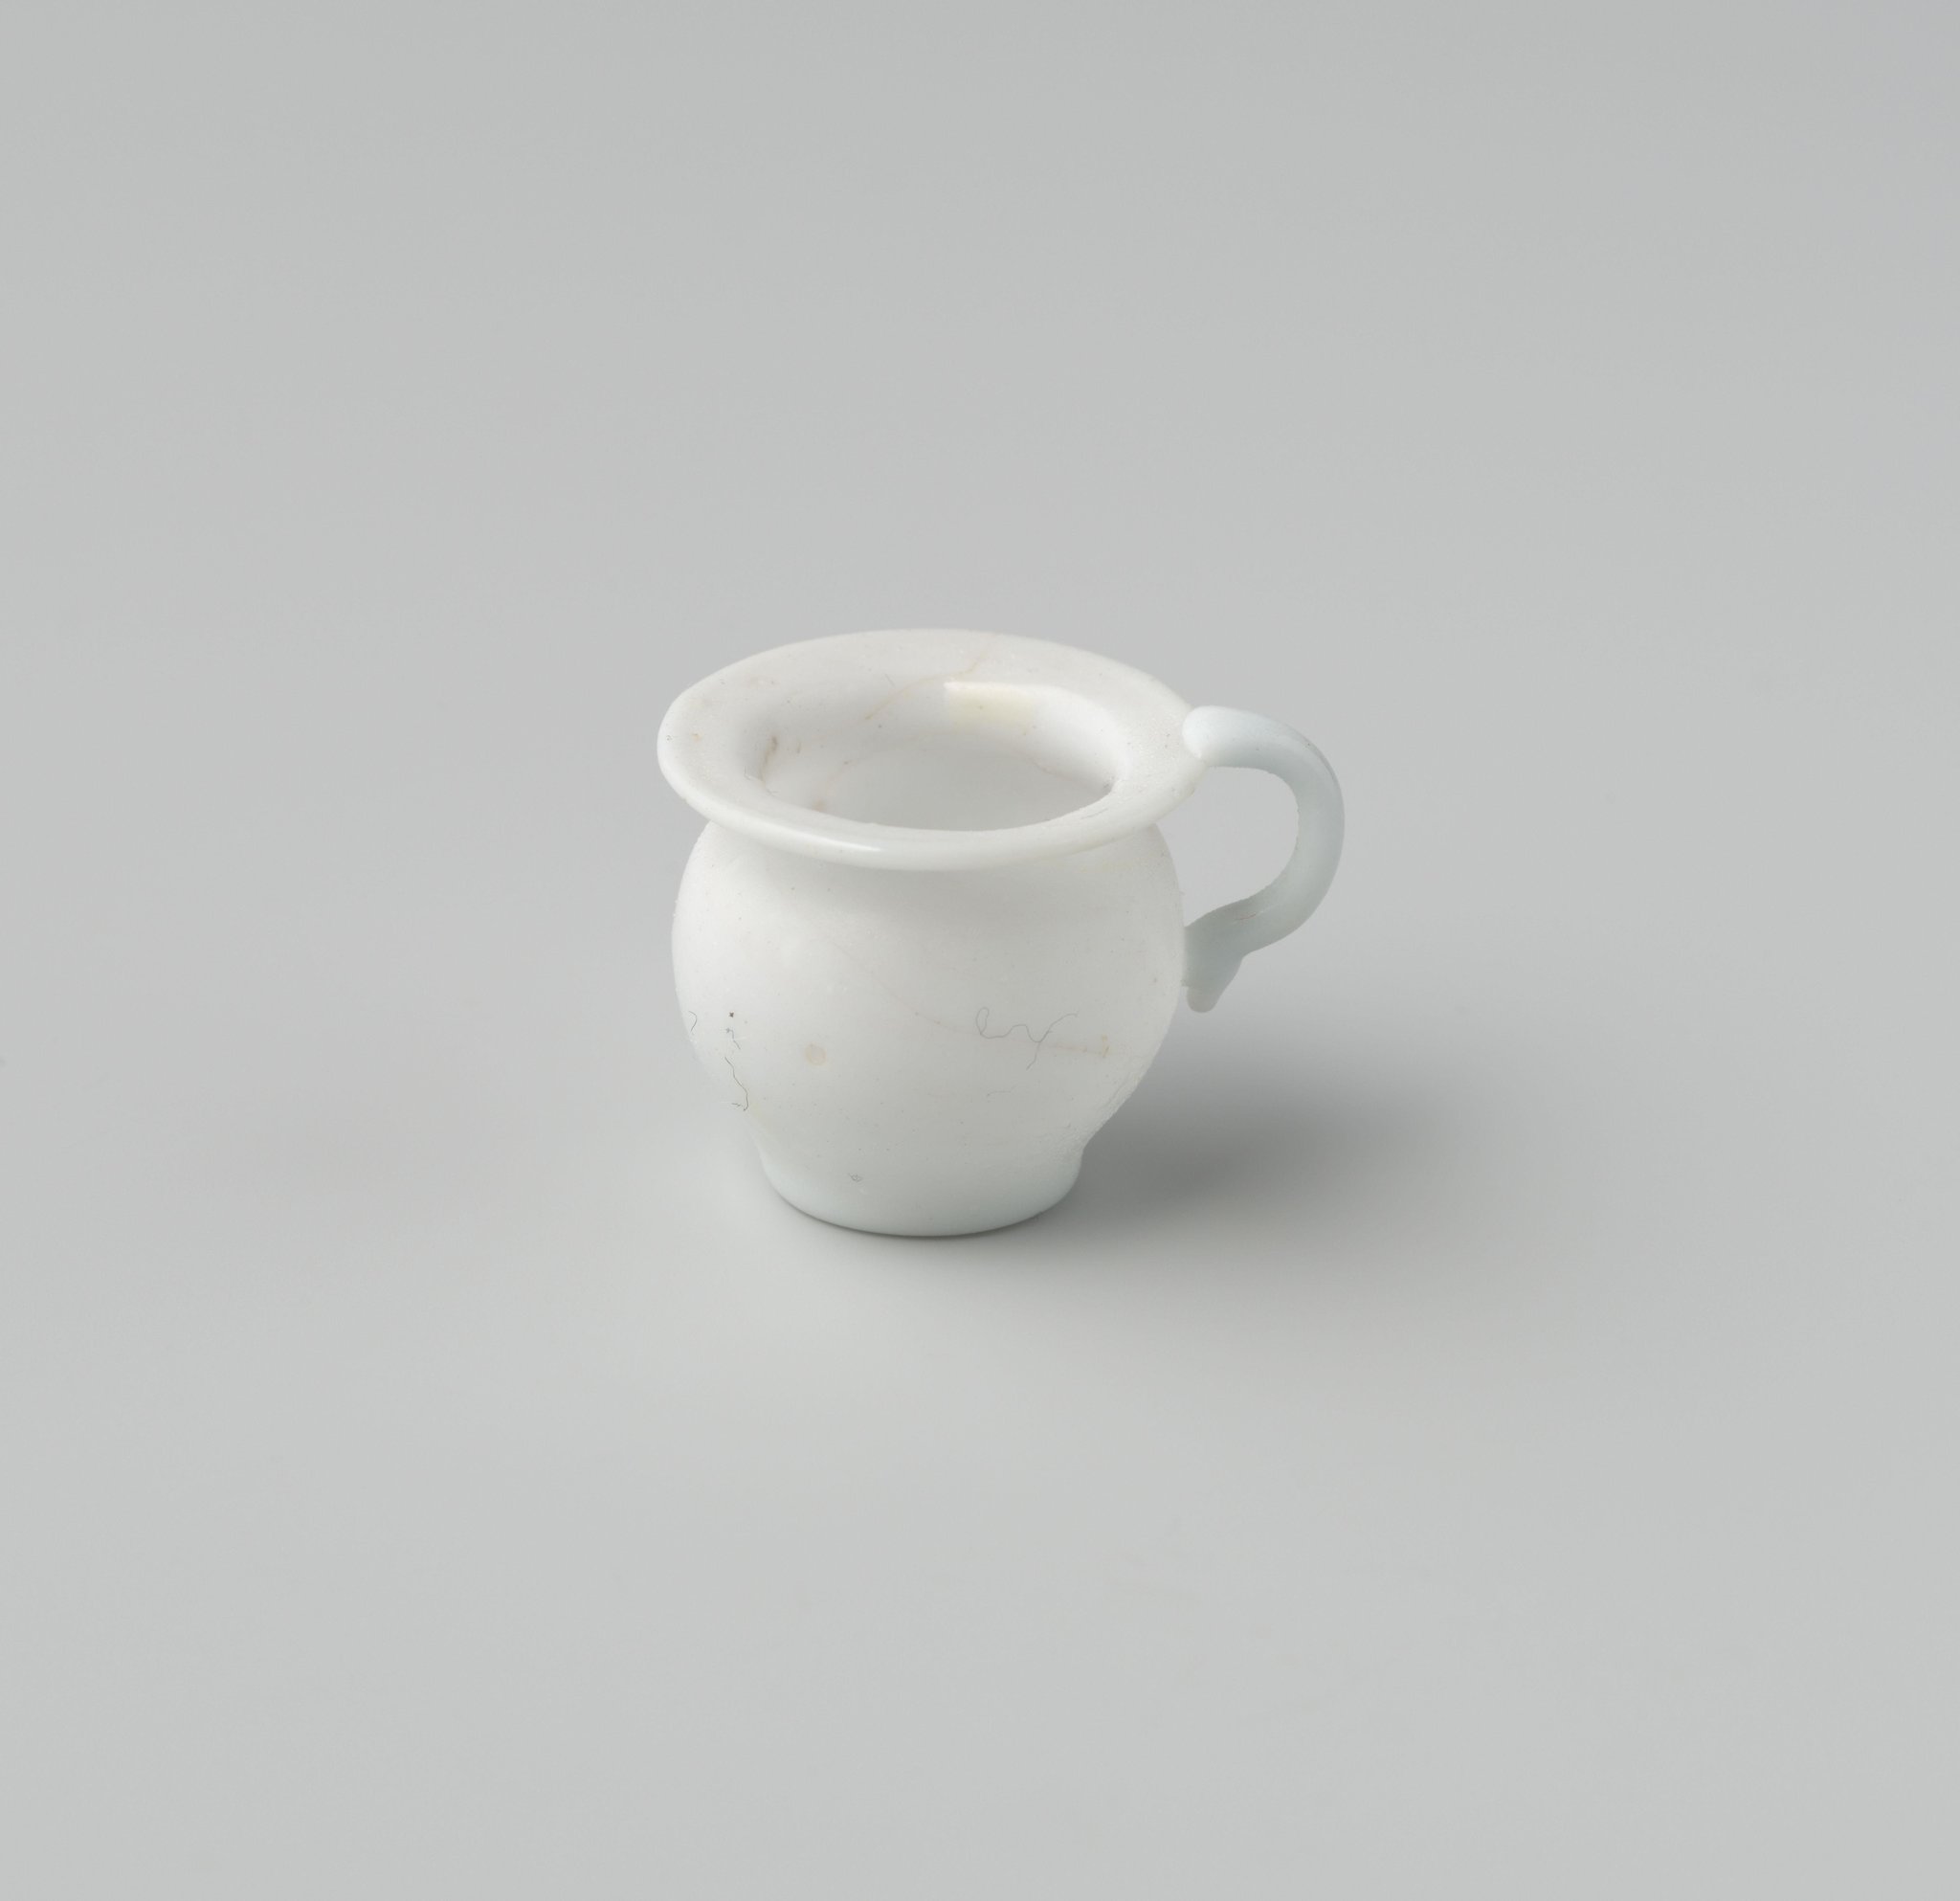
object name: pot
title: Kamerpot van opaak wit glas (waarschijnlijk imitatie wit aardewerk); vrij hoog model met naar binnen gestoken bodem, vlakke halsrand en een aangezet oor.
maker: Anonymous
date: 1675-1710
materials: glass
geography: amsterdam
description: Kamerpot van opaak wit glas, waarschijnlijk imitatie wit aardewerk; vrij hoog model met naar binnen gestoken bodem, vlakke halsrand en een aangezet oor.